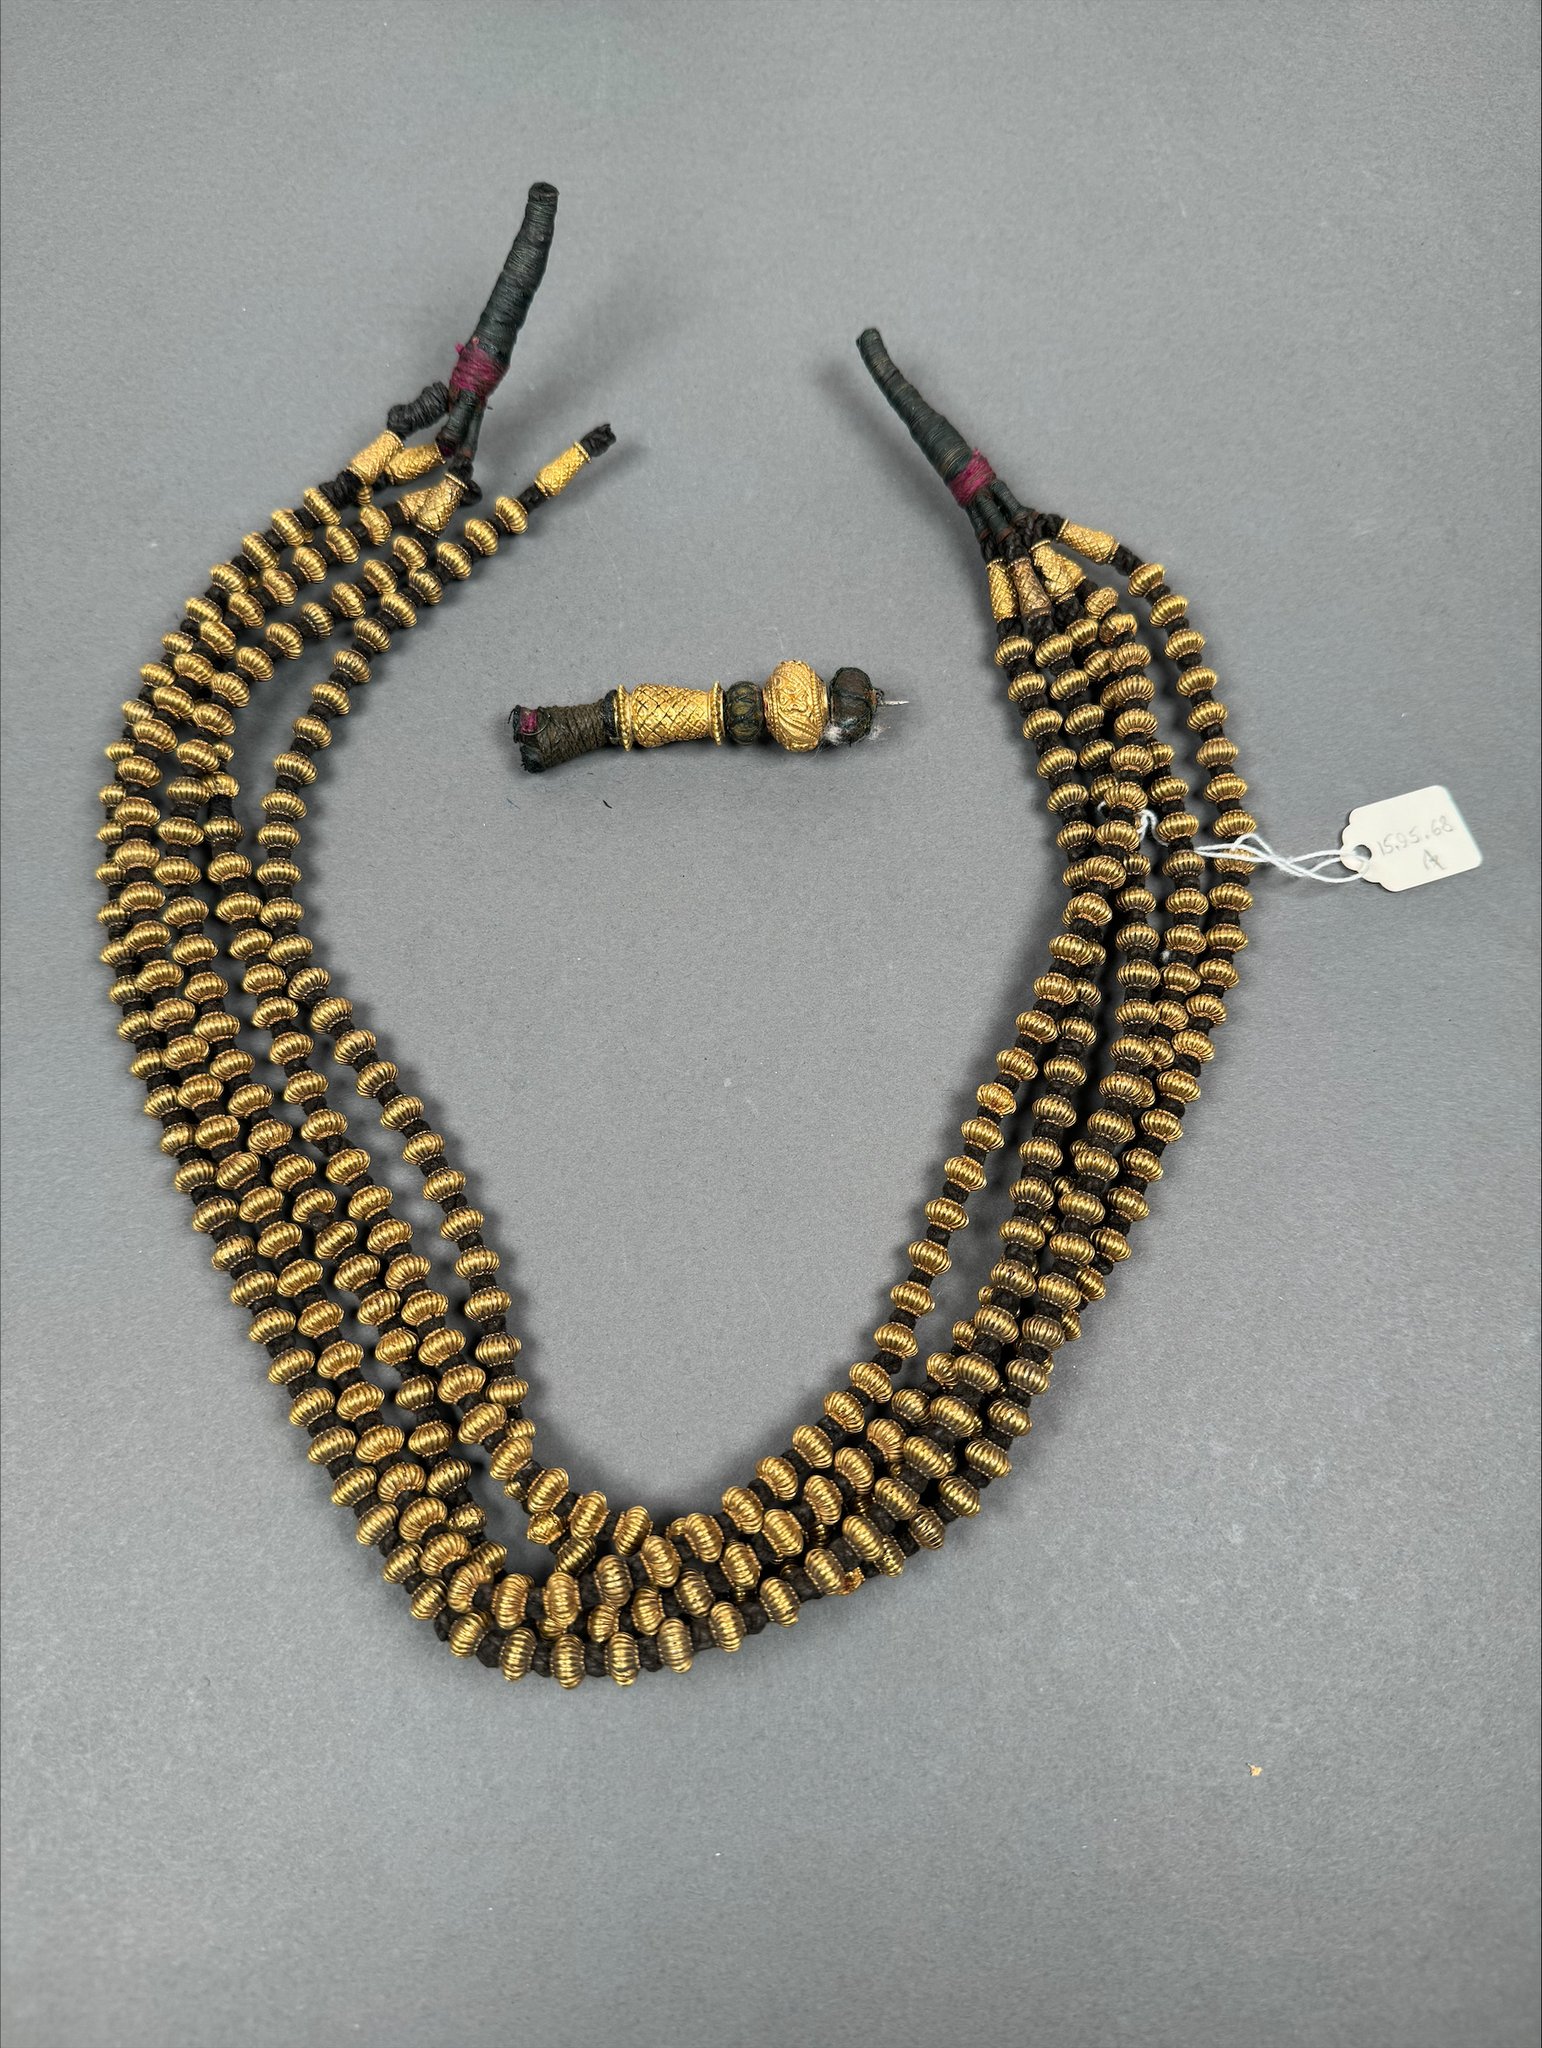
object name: necklace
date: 1701-1900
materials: gold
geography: india